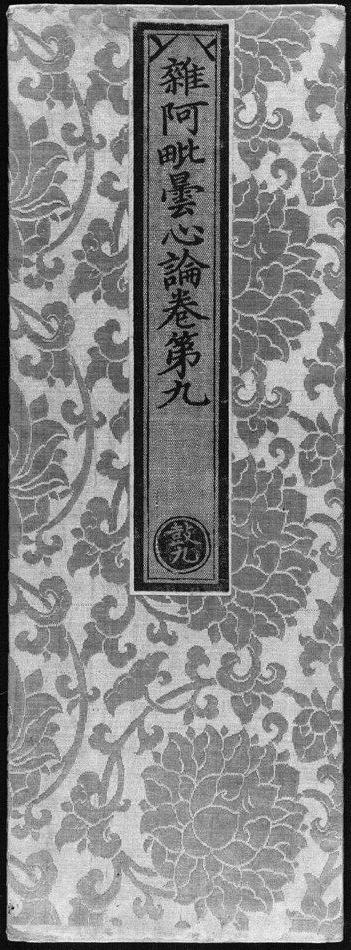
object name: sutra cover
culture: chinese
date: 1501-1600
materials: silk